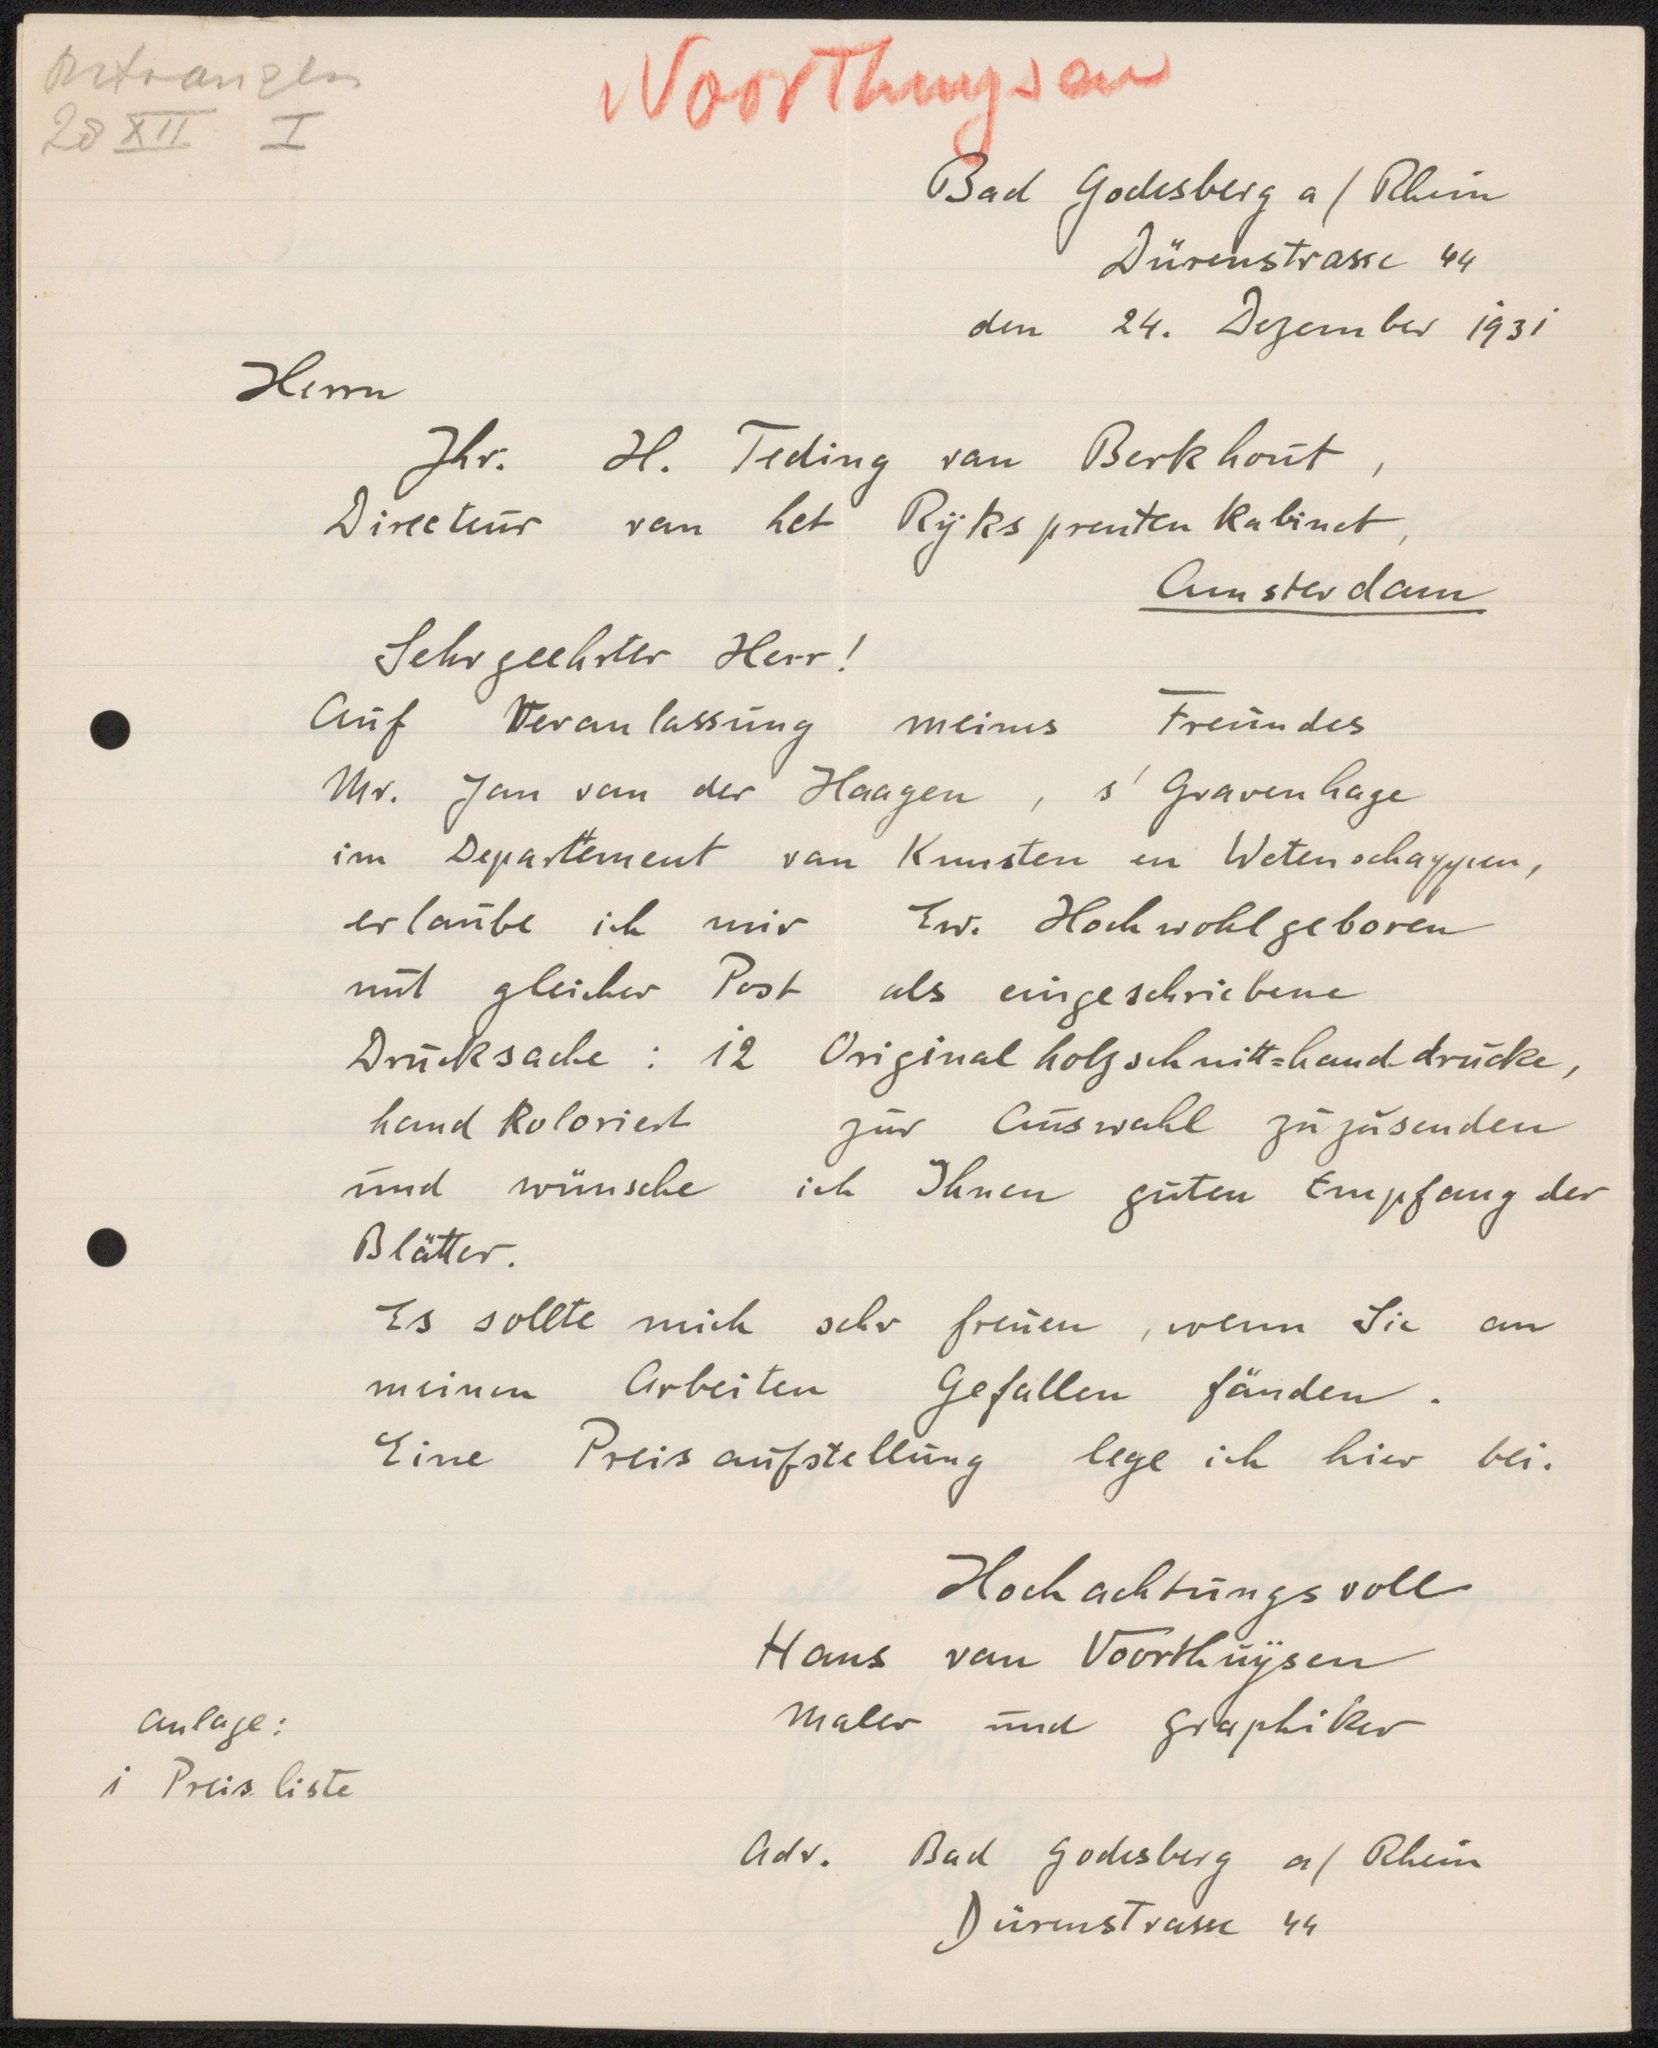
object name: letter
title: Brief aan jonkheer Hendrik Teding van Berkhout (1879-1969)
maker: hans van voorthuijsen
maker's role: painter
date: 1931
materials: ink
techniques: pen, writing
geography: bad godesberg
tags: haarlem, amsterdam, jonkheer hendrik teding van berkhout (1879-1969), the graphic arts, money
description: Brief bevat briefkaart betreffende teruggezonden werken.